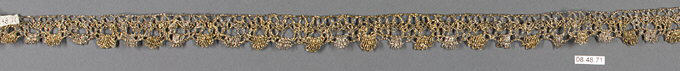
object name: fragment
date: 1830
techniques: lace